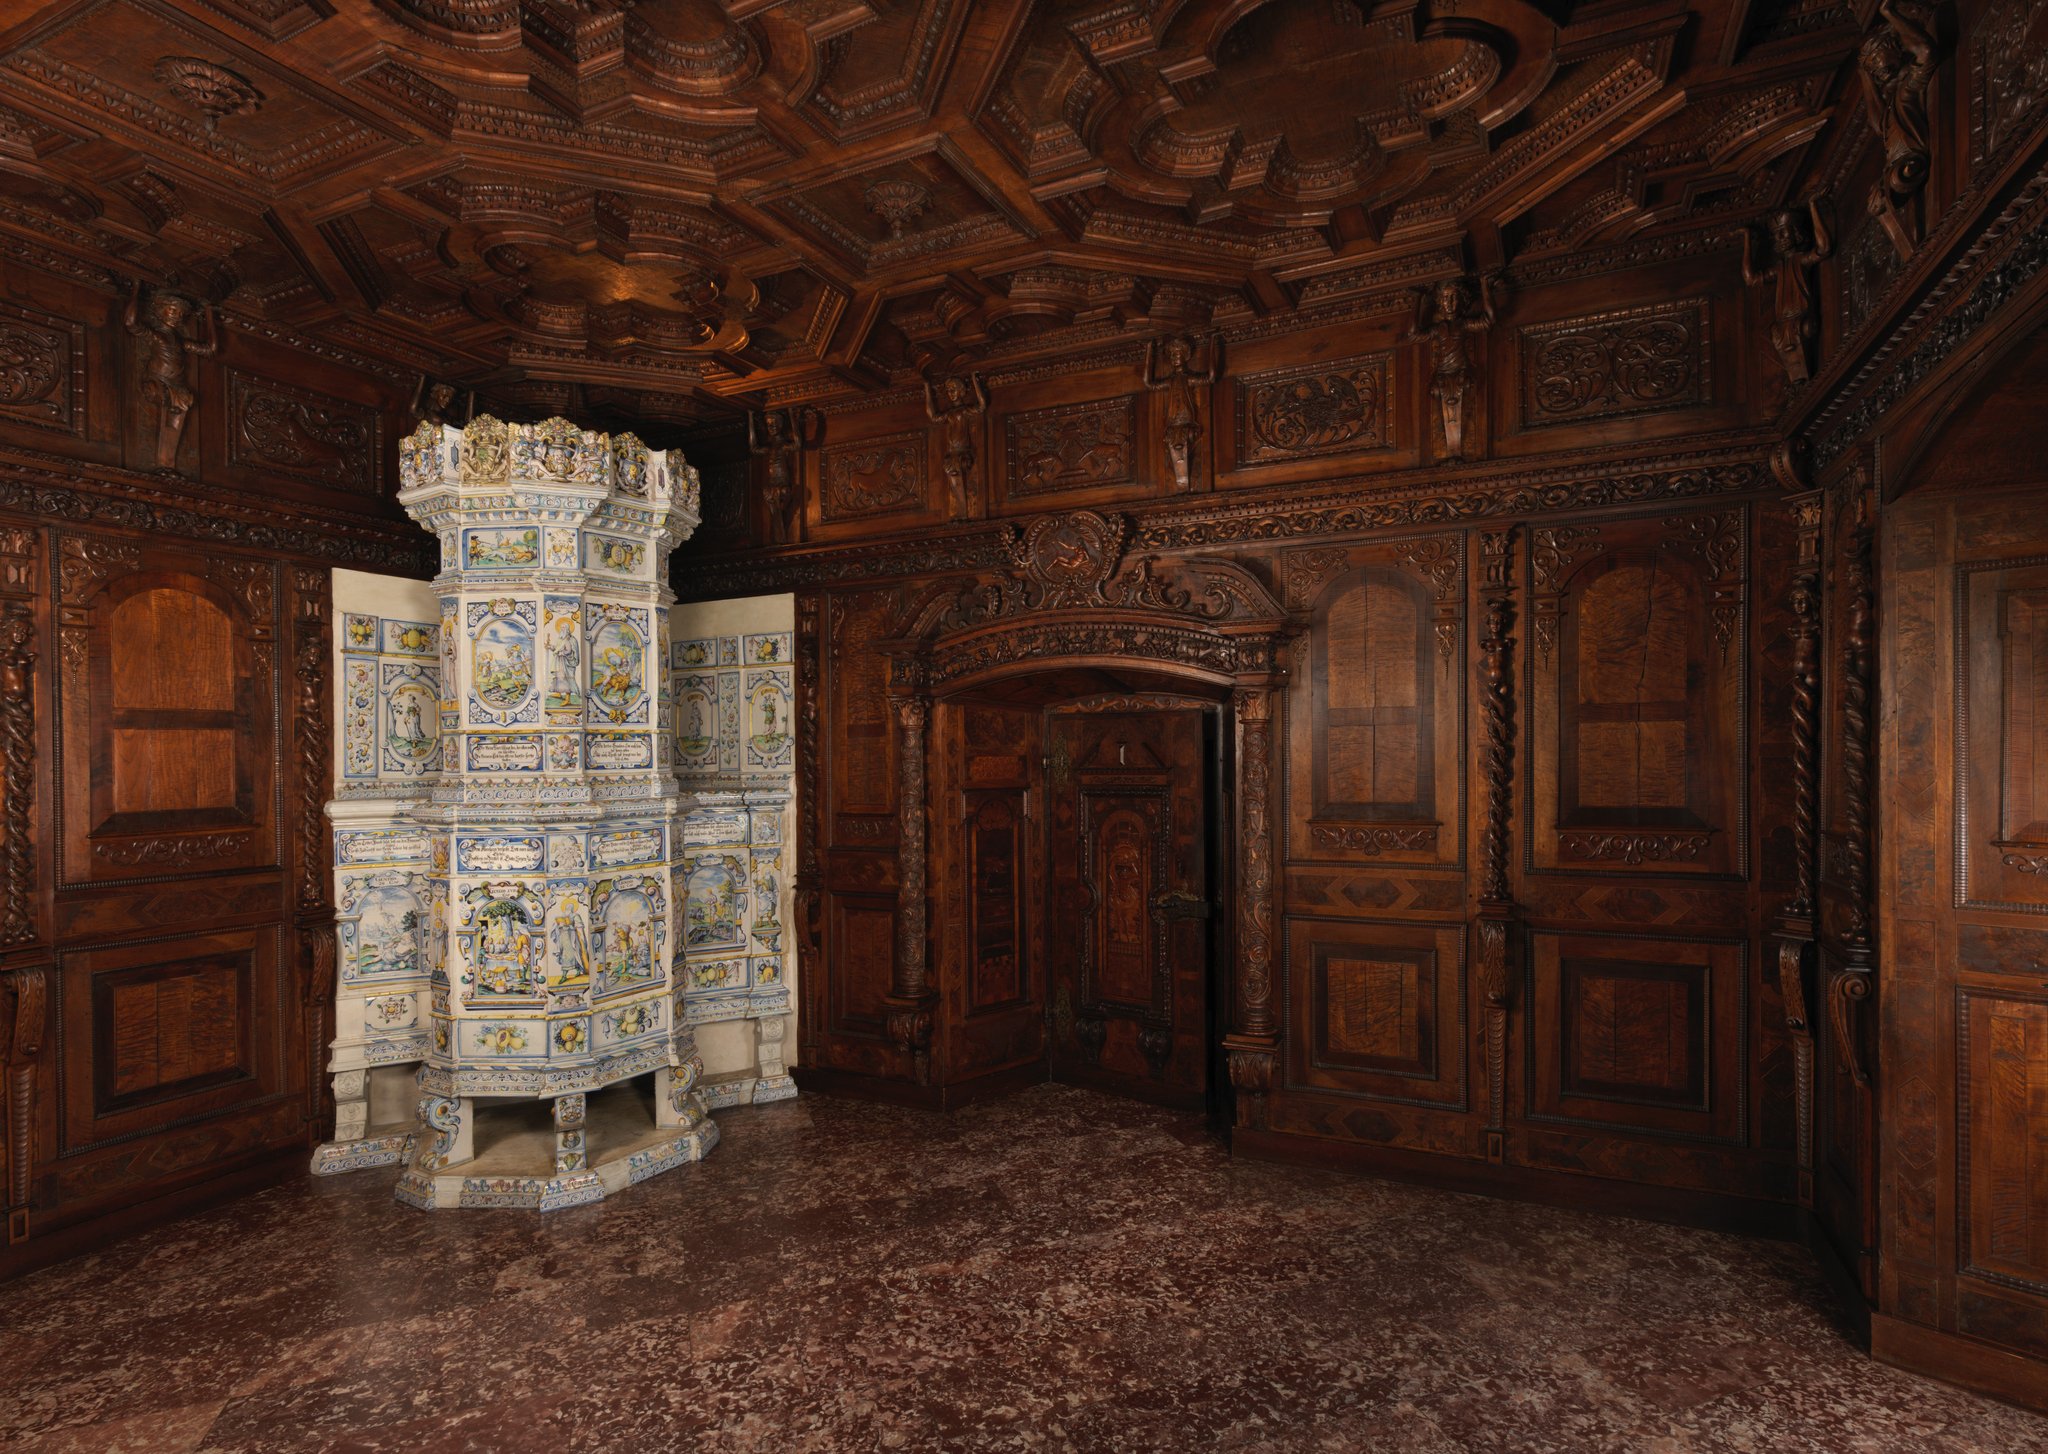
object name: period room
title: The Swiss Room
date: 1682-1684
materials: wood